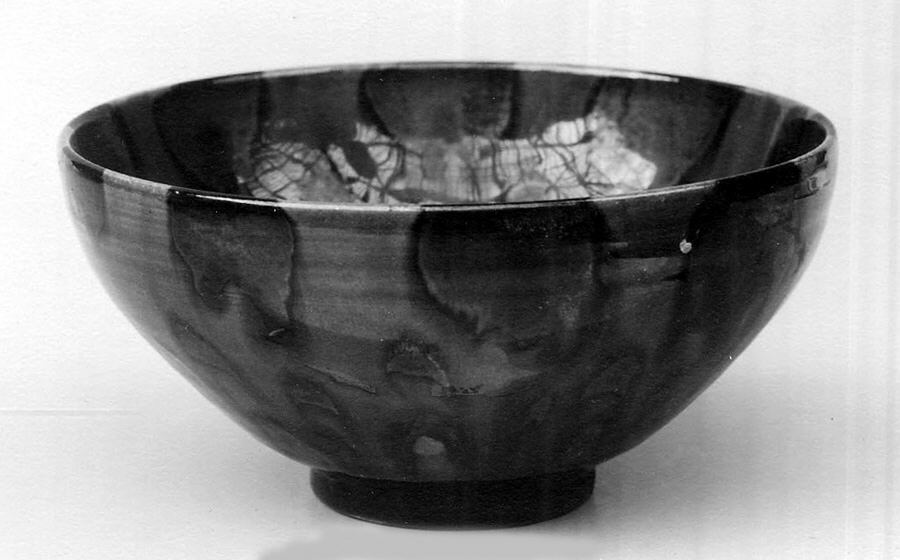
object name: teabowl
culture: japanese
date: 1853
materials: clay, glaze